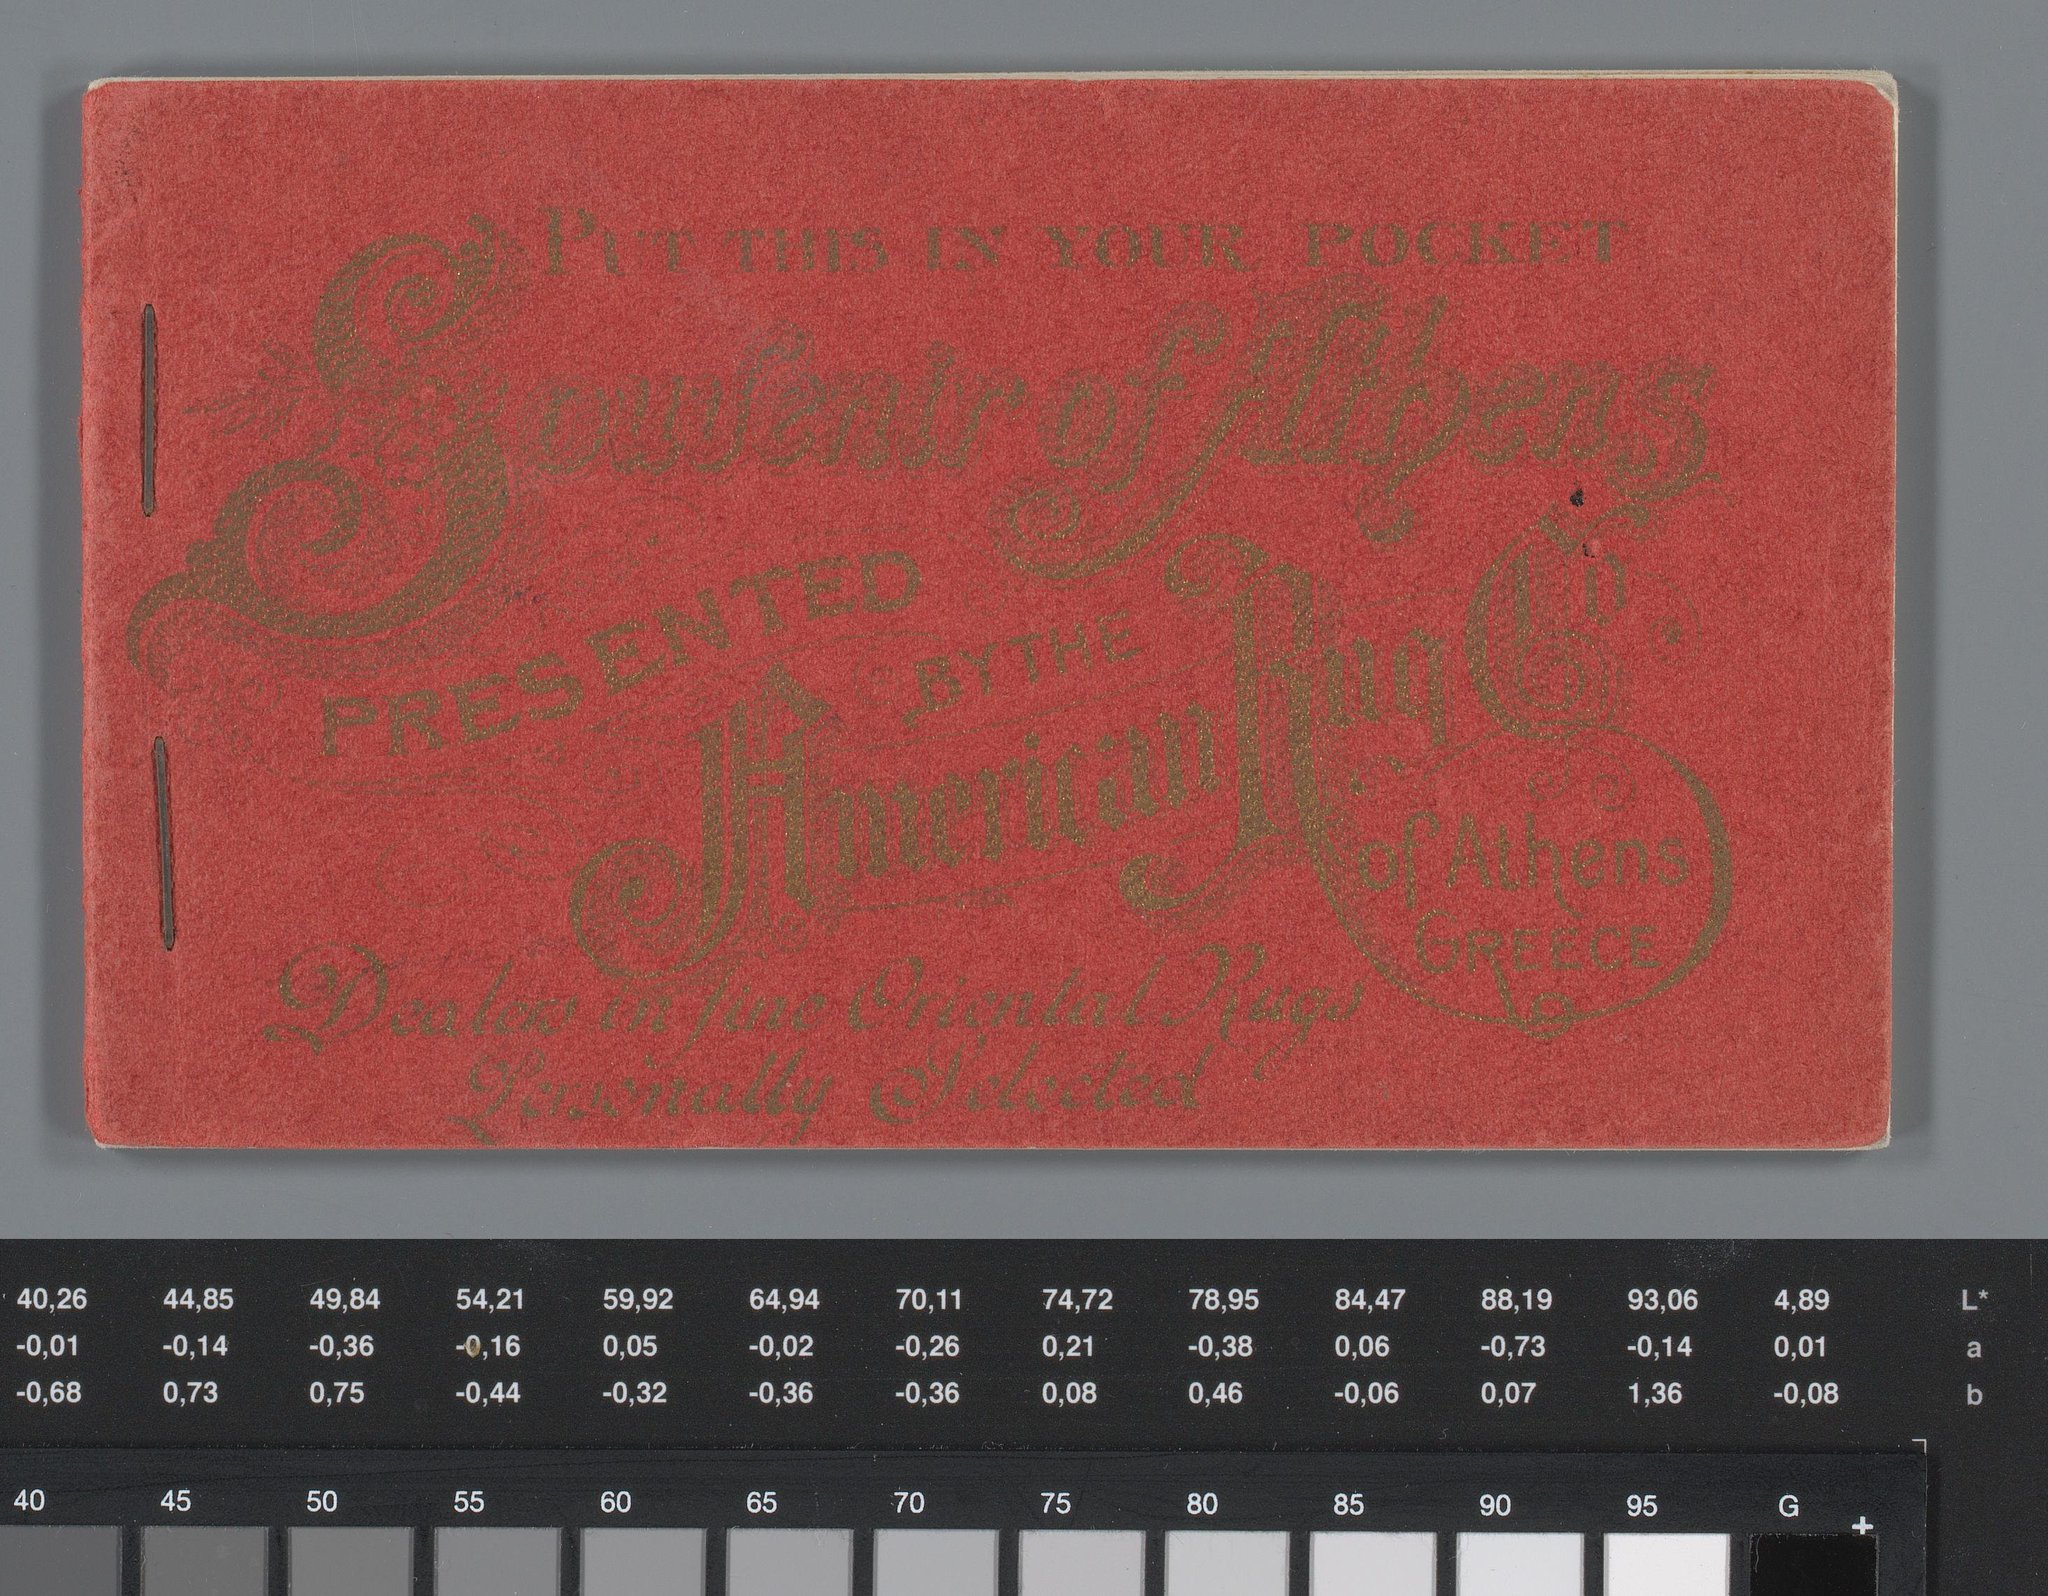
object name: book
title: Souvenir of Athens presented by the American Rug Co. of Athens Greece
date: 1896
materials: paper, photographic support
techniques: albumen print, letterpress printing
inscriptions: inscription: ‘$200’, date: ‘SEPT 2006’